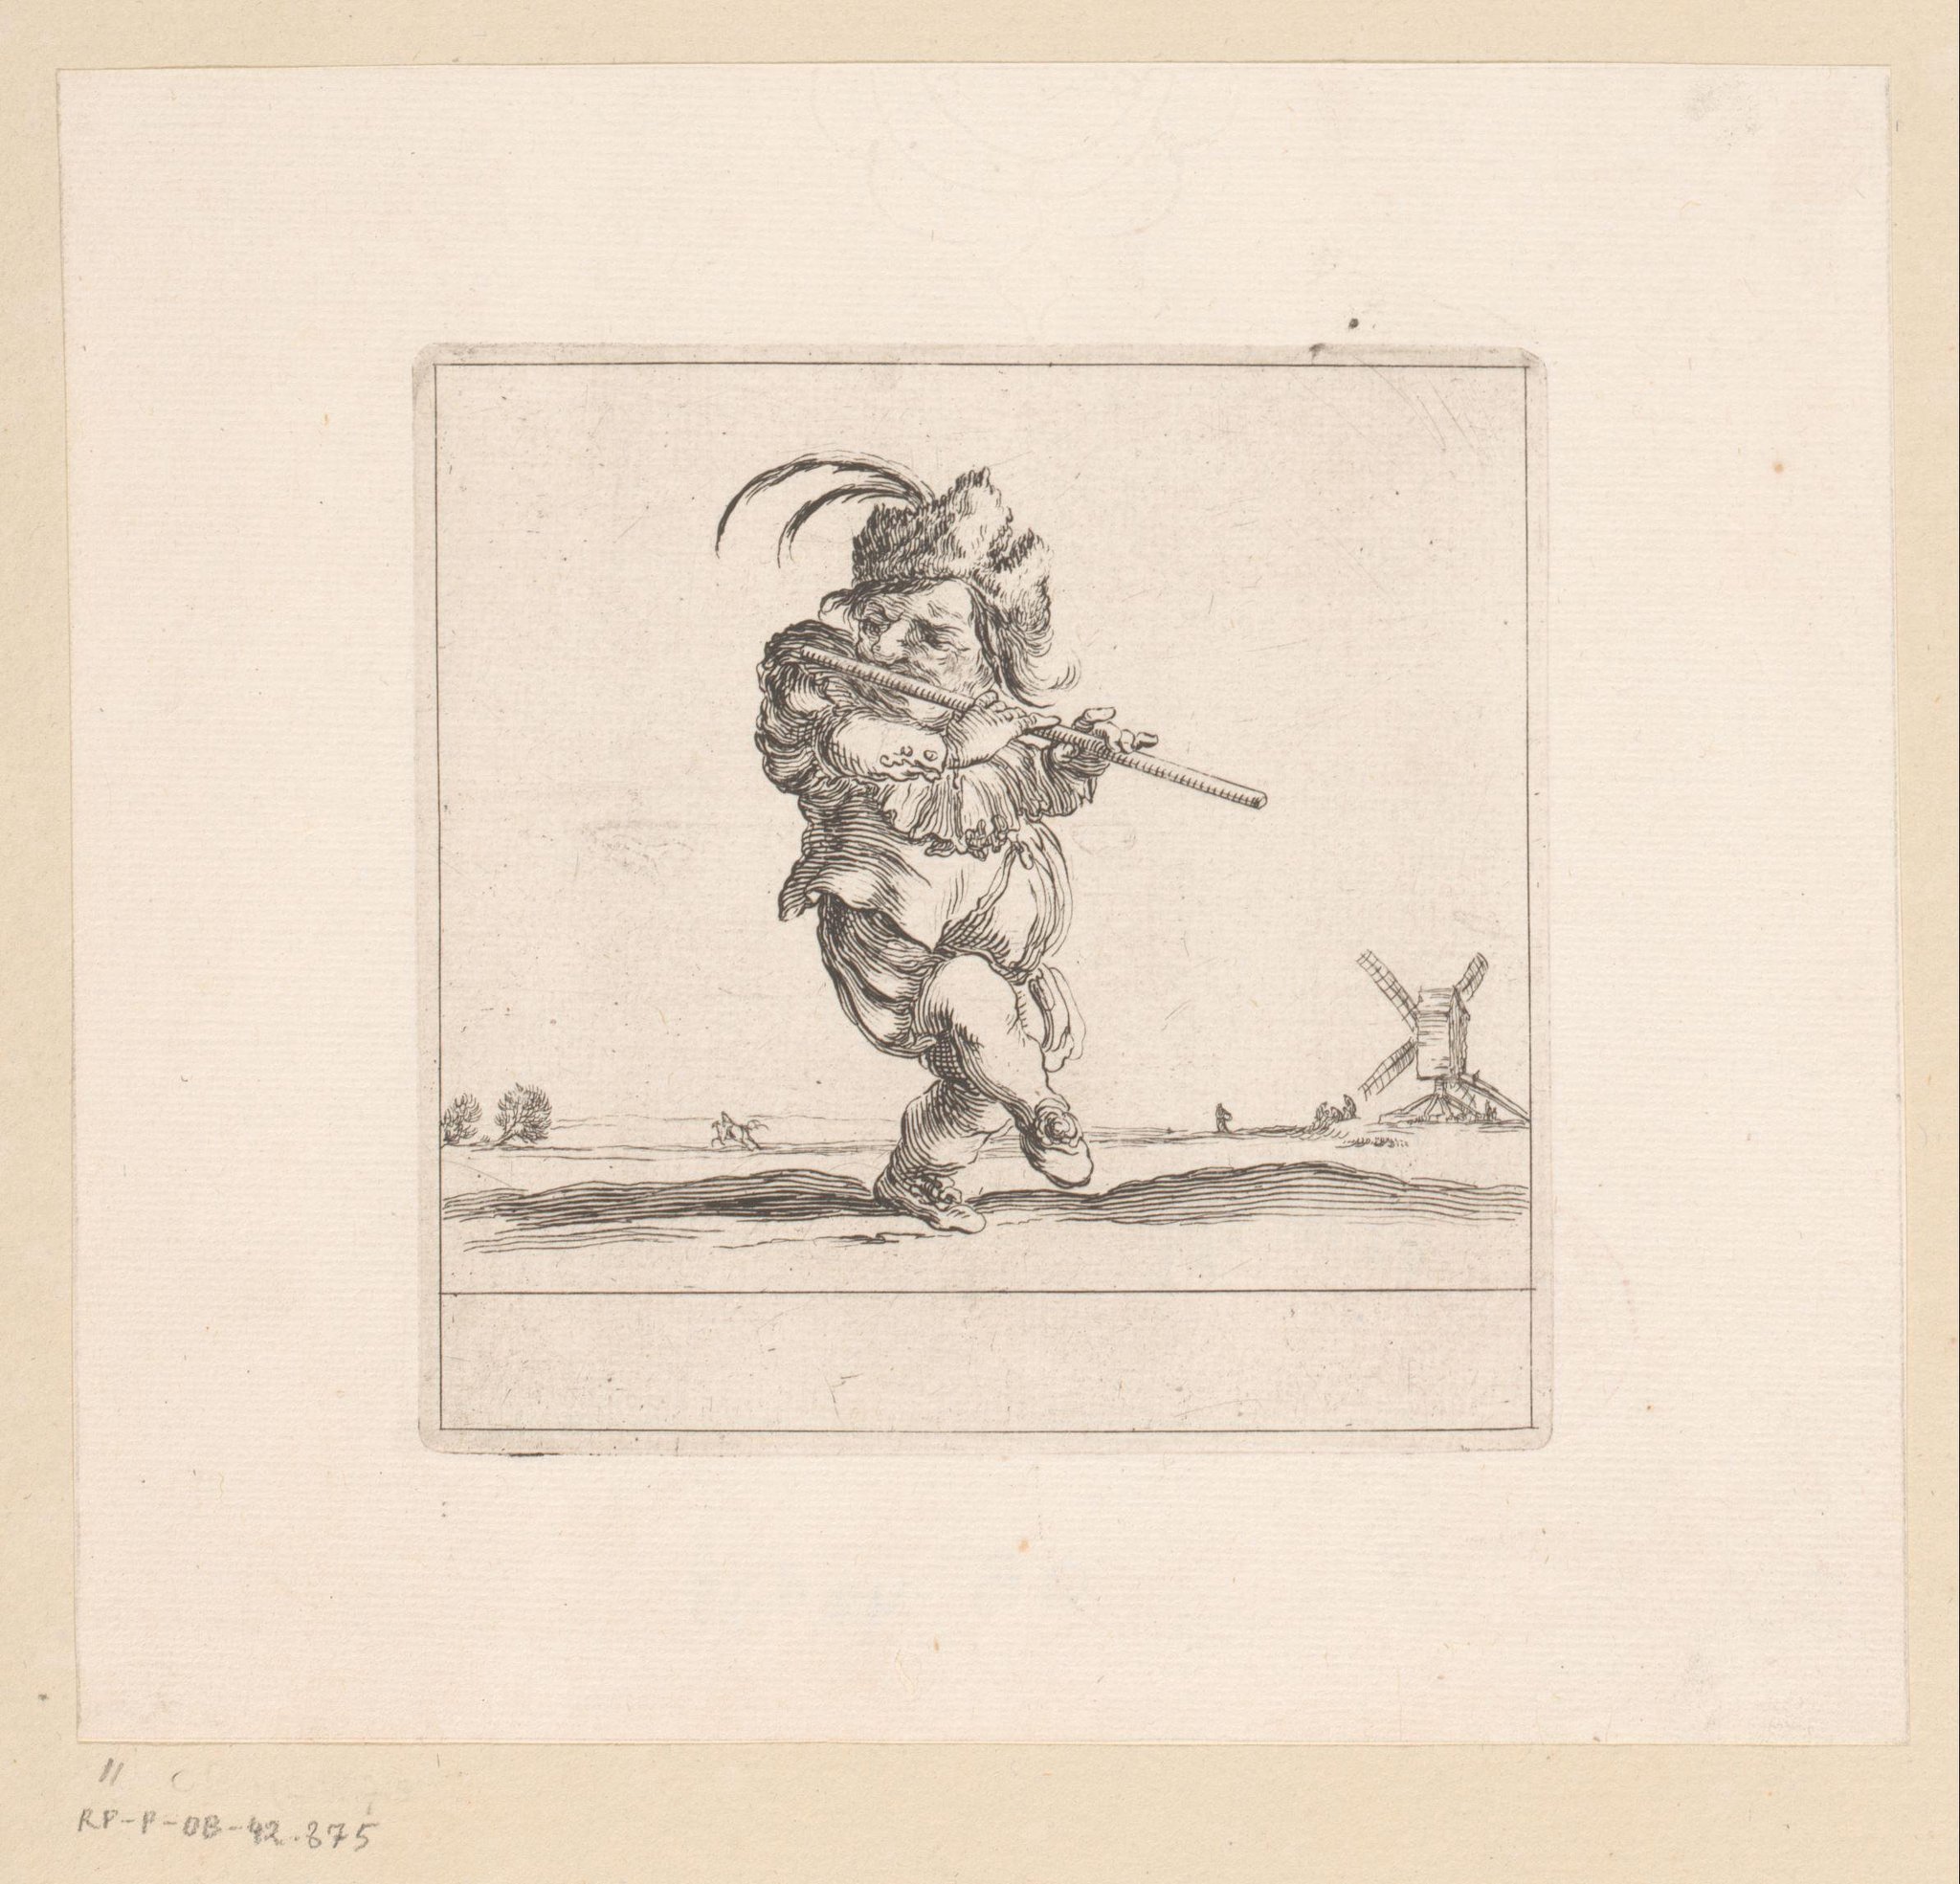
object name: print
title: Karikatuur van een fluitspelende man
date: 1620-1687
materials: paper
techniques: etching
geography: italy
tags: transverse flute - cc - out of doors, caricatures (human types), adult man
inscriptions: collector's mark: Lugt 240